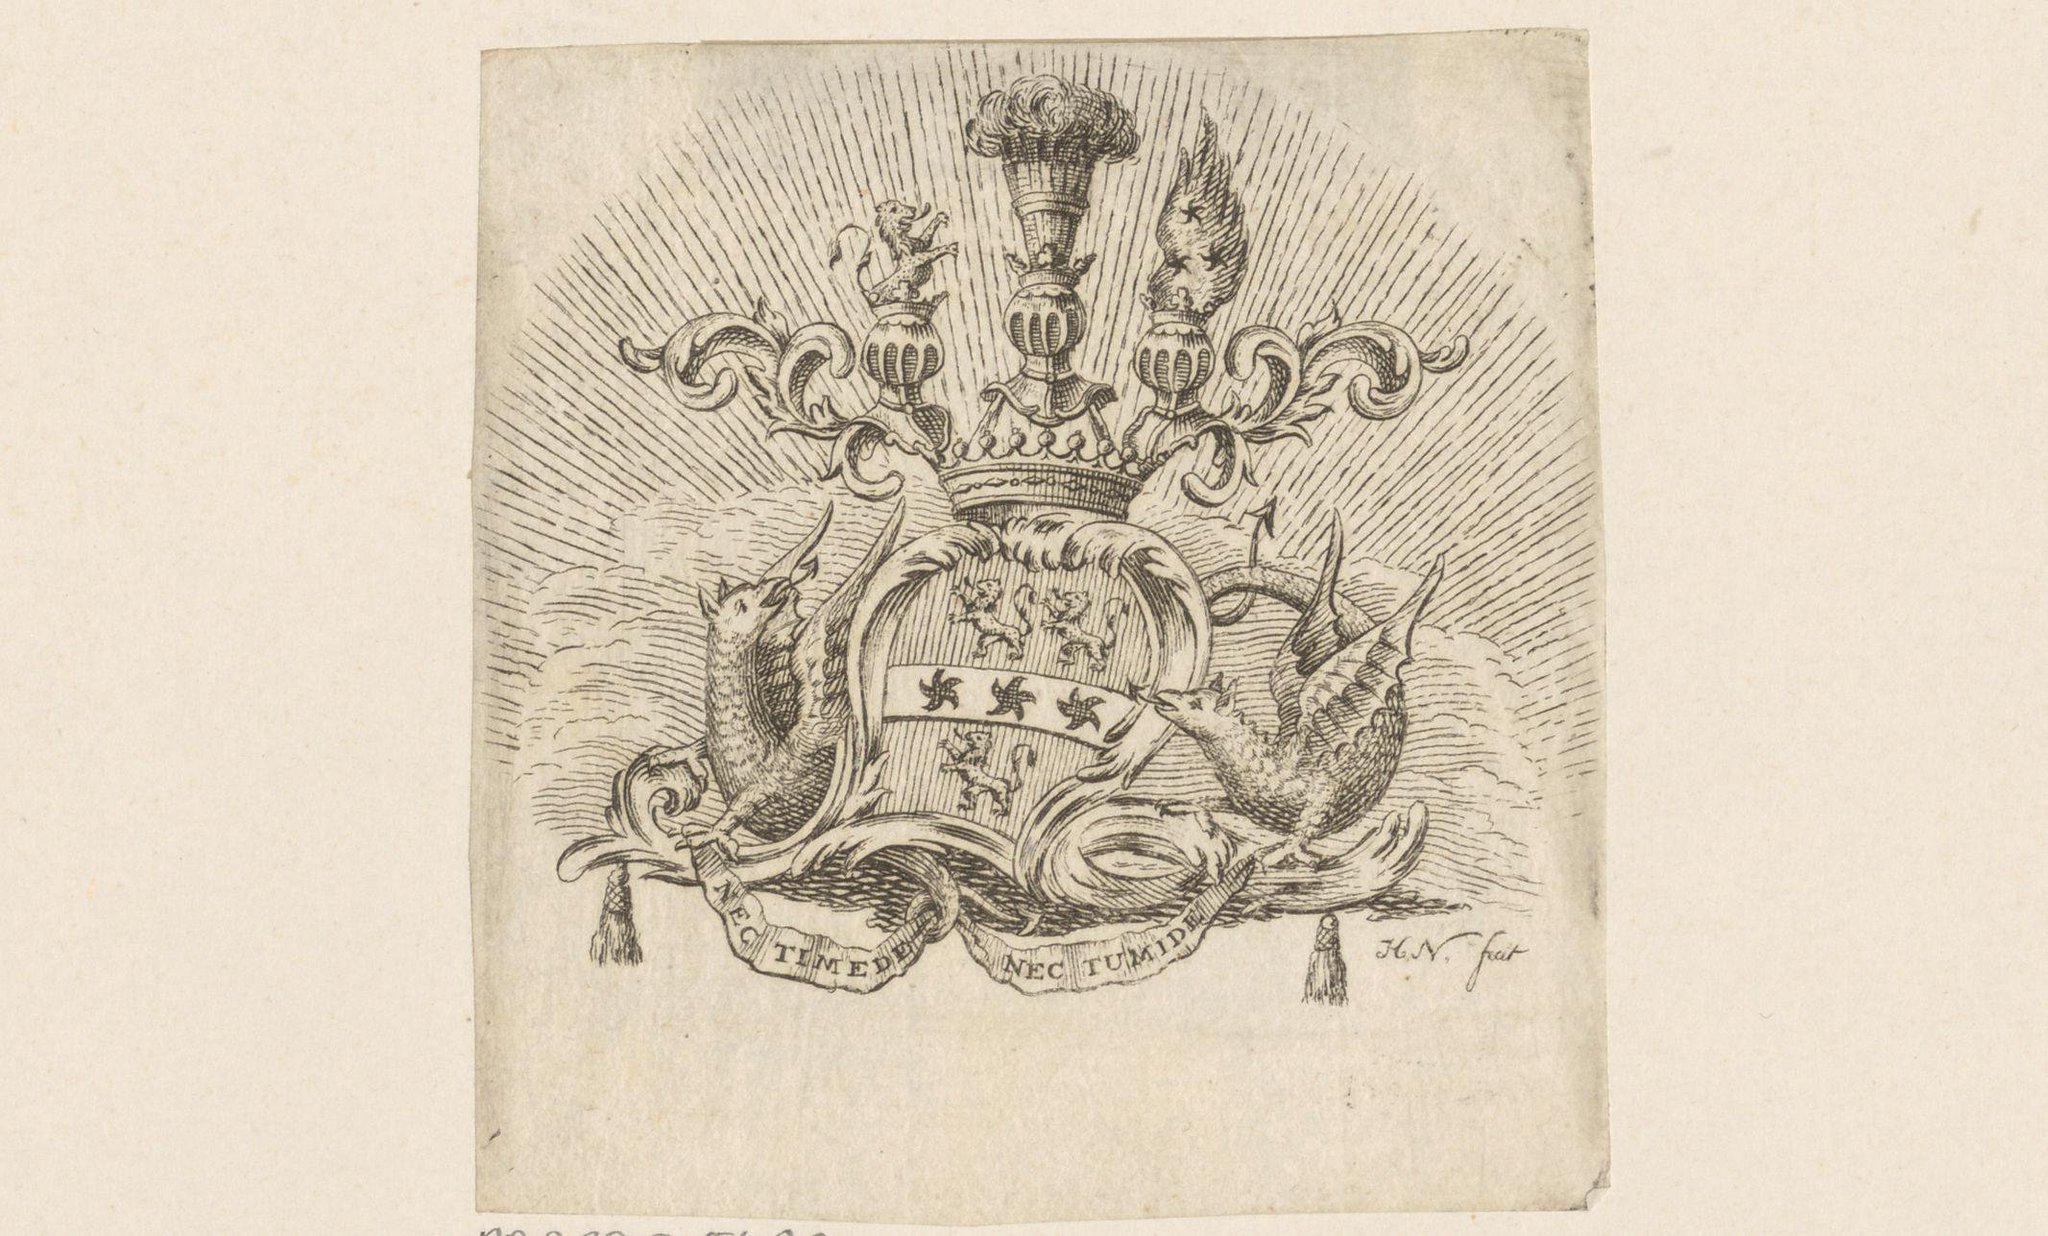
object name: bookplate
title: Nec timede, nec tumide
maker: Anonymous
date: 1700-1799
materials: paper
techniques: etching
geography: austria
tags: dragon, armorial bearing, heraldry